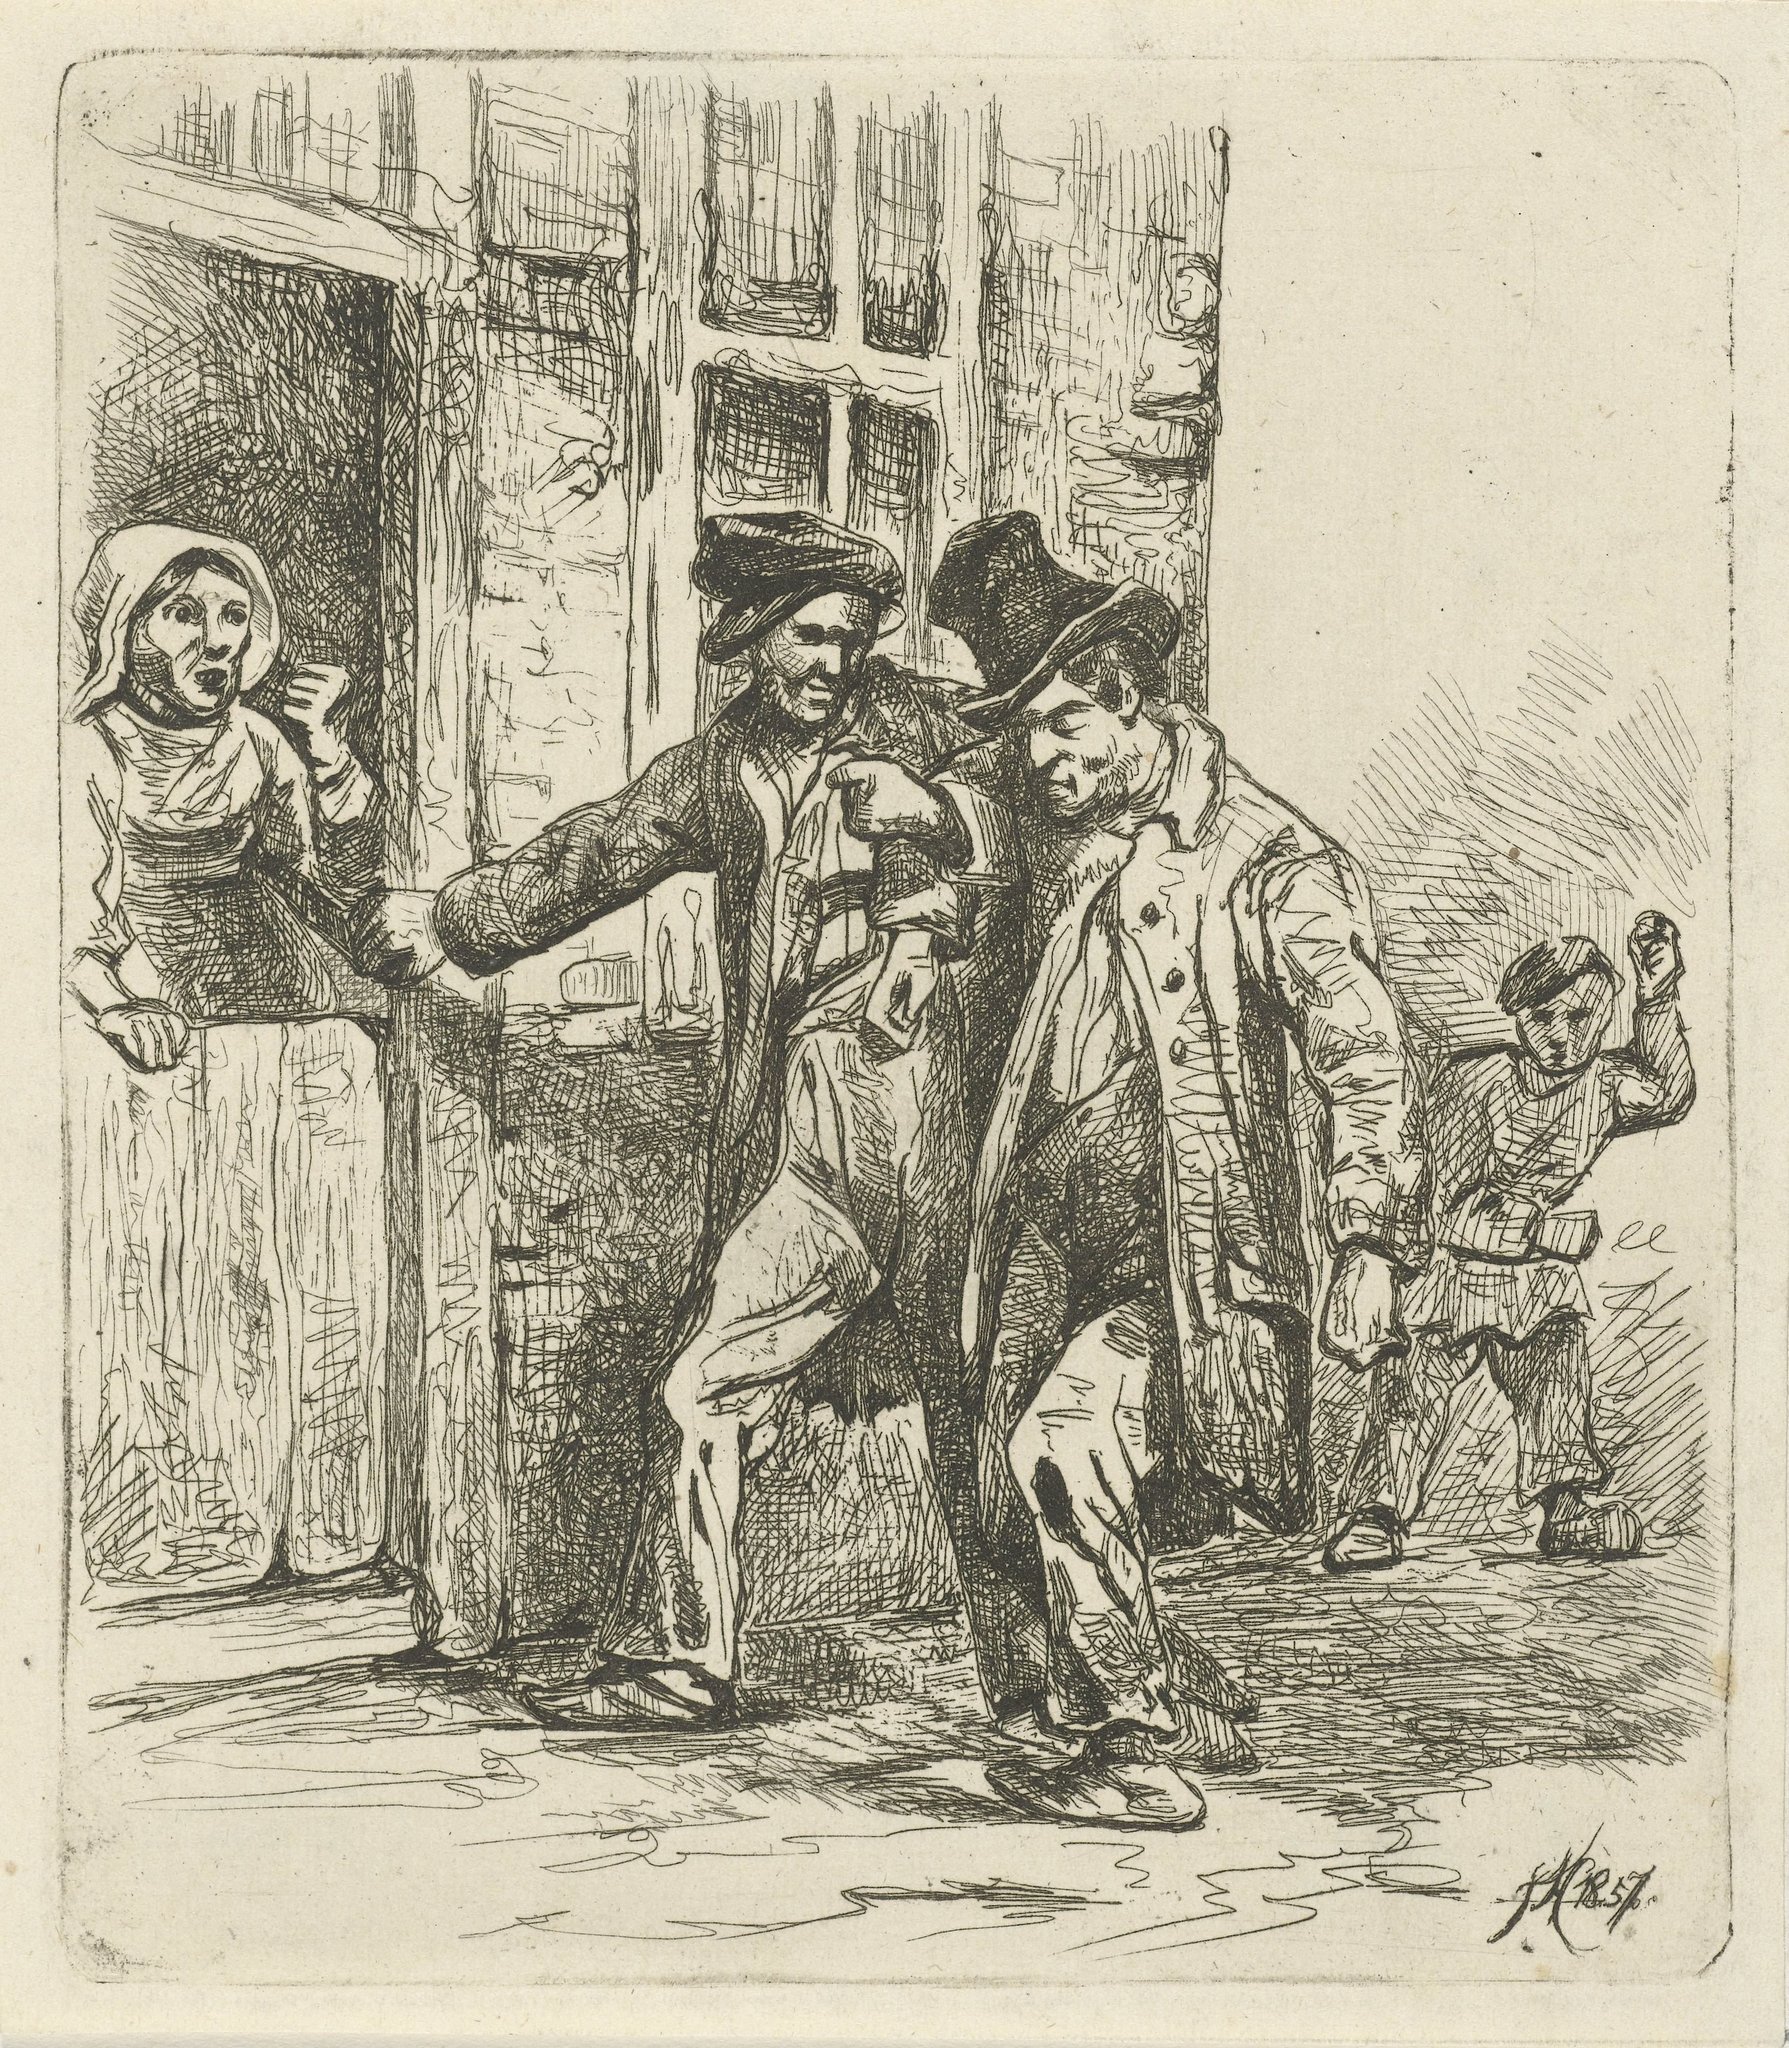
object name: print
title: Twee dronkaards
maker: jozef hoevenaar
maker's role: draughtsman, print maker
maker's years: 1840-1926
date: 1857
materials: paper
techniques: etching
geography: utrecht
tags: drunkard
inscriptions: collector's mark: Lugt 2228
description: Twee beschonken mannen in een straat, de een de ander bij de arm ondersteunend. Links een vrouw achter een onderdeur met haar linkervuist opgeheven. Op de achtergrond een jongen met geheven arm.